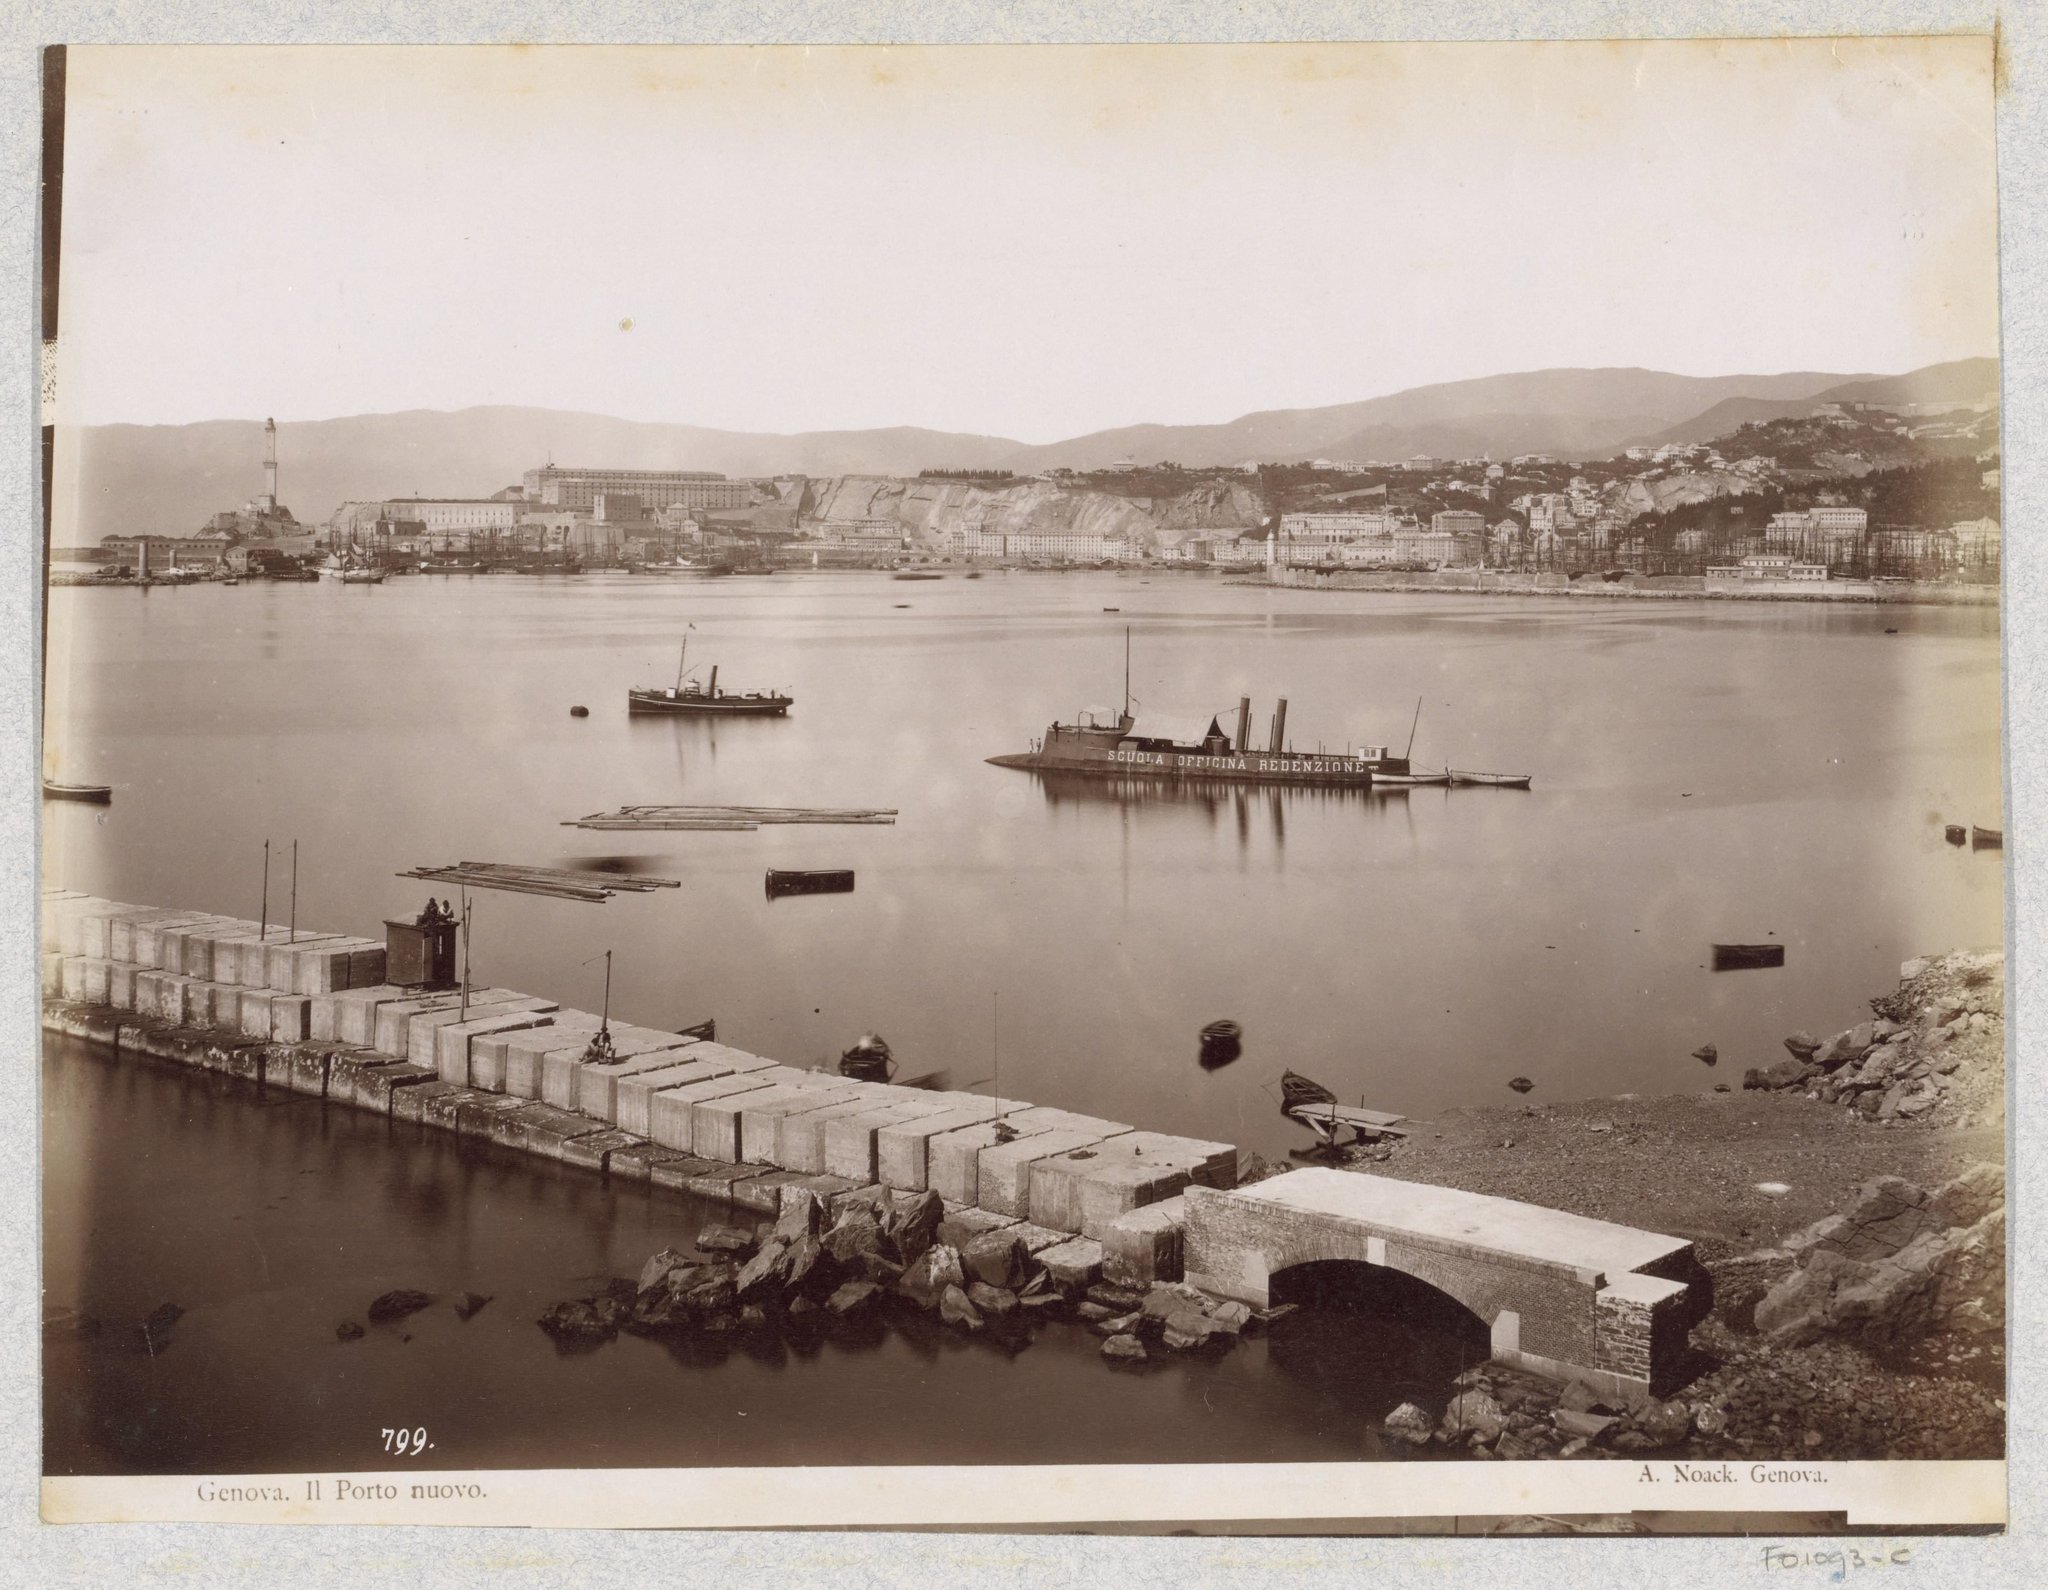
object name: photograph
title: Genova. Il porto nuovo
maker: alfredo noack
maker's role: fotograaf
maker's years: 1833-1895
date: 1870-1890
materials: paper, photographic support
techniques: albumen print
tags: harbour (+ view ~ vehicle, ship, etc.), pier, quay, wharf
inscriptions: negative number: ‘799’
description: Onderdeel van Reisalbum met foto's van bezienswaardigheden in Genua, Florence en Venetië.